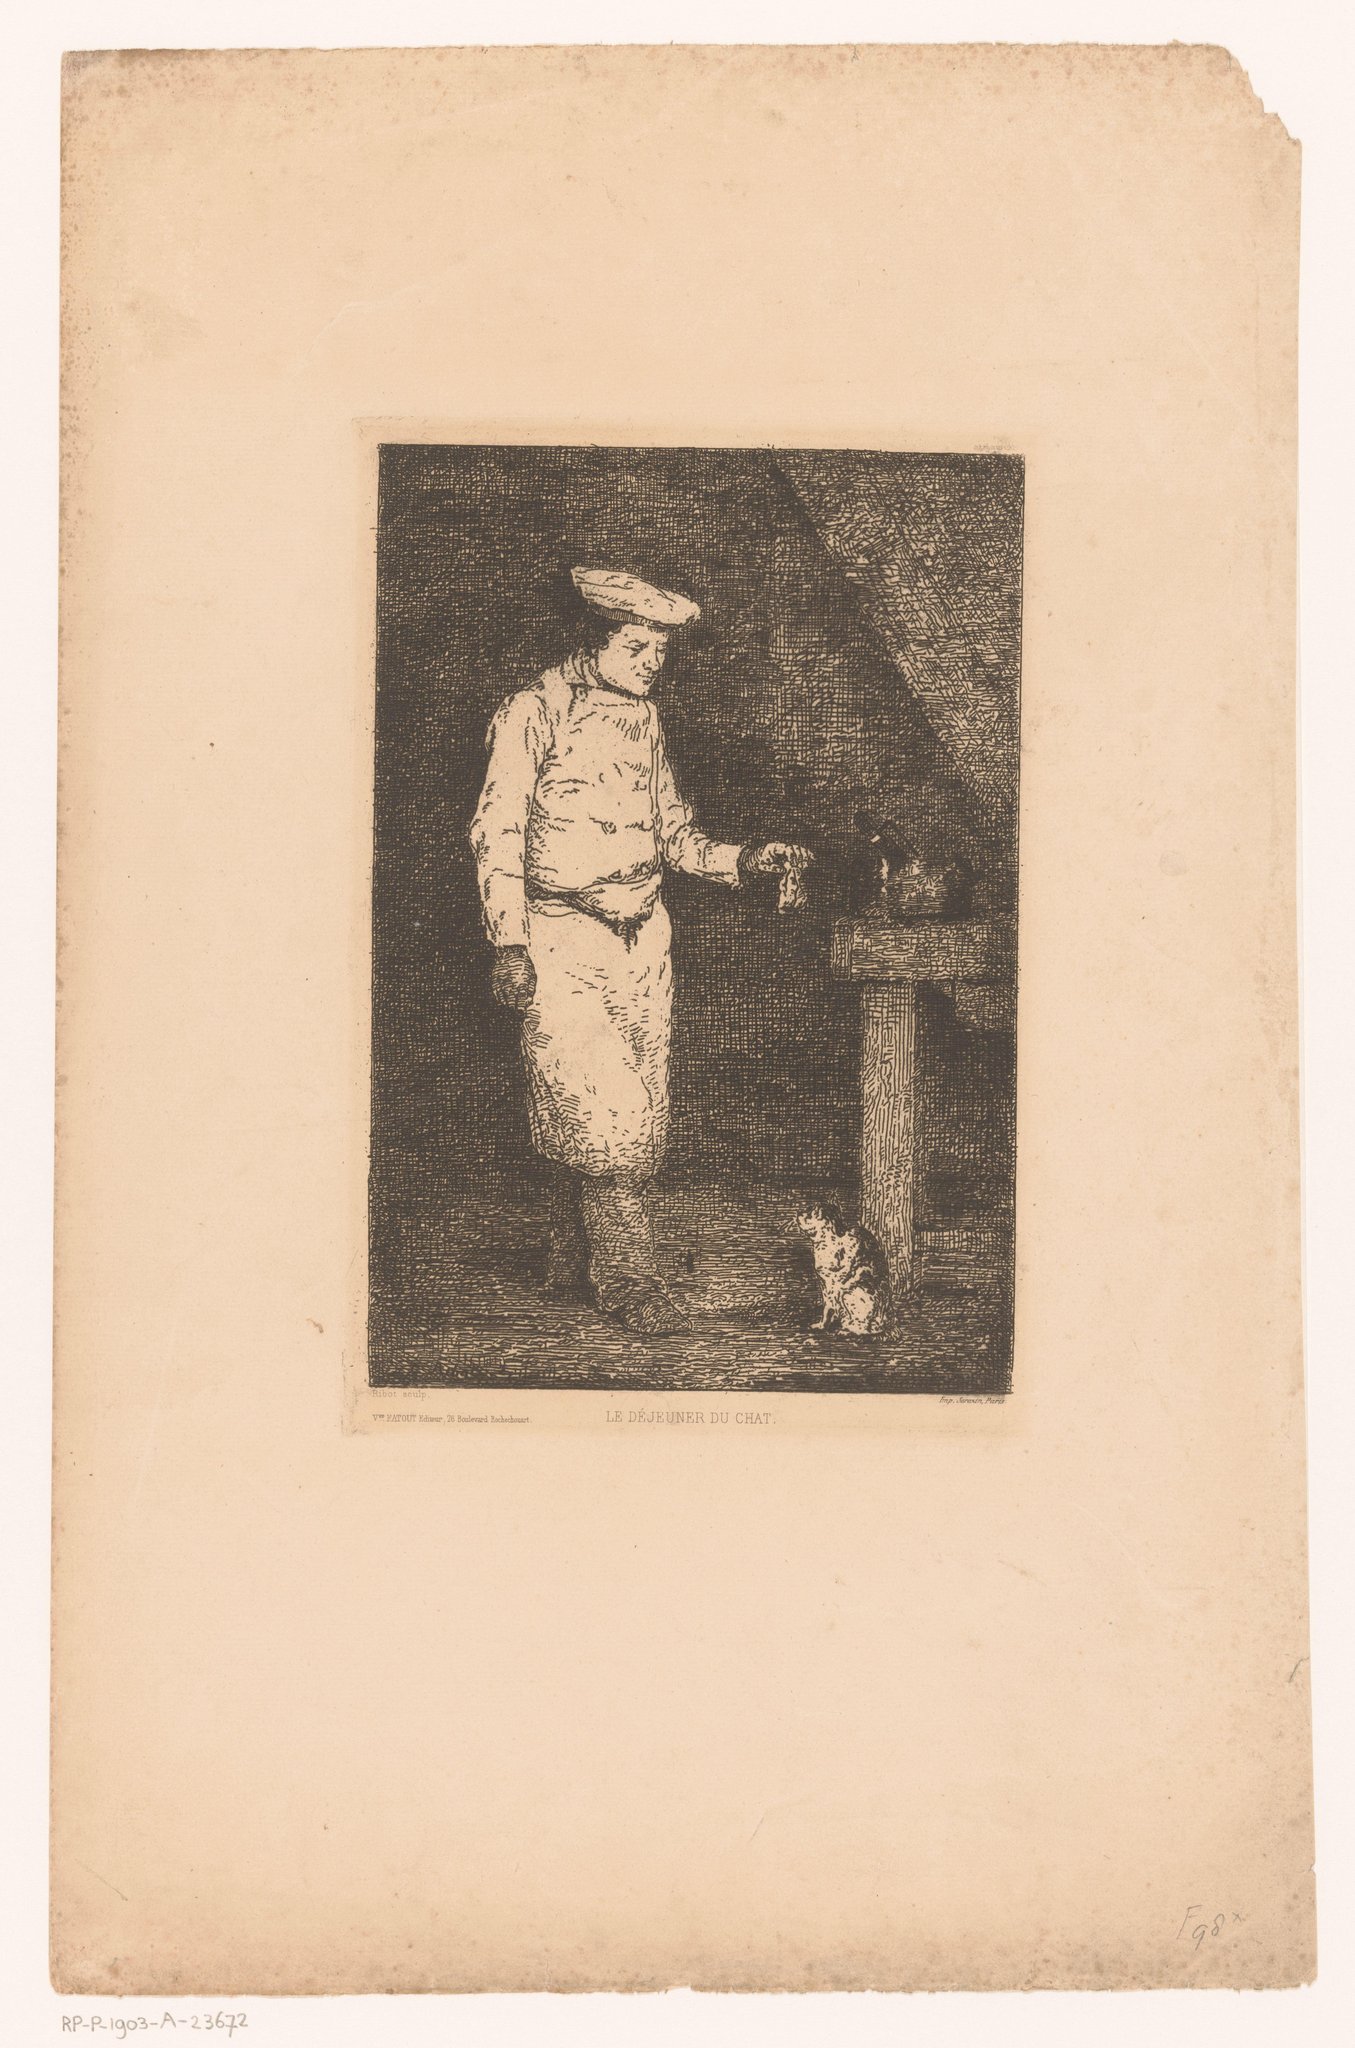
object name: print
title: Donker interieur met een kok die een stuk vlees ophoudt voor een kat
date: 1867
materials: paper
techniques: etching, intaglio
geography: paris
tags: cat, cook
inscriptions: collector's mark: Lugt 2228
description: Maakt deel uit van het eerste volume van een serie prenten door de Société des Aquafortistes uit 1867. Plaat 289.